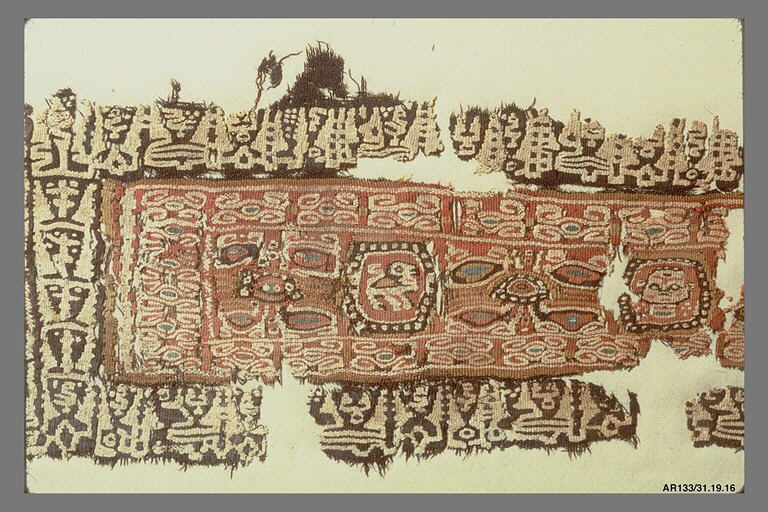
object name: textile fragment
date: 801-900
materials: linen, wool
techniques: weave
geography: egypt